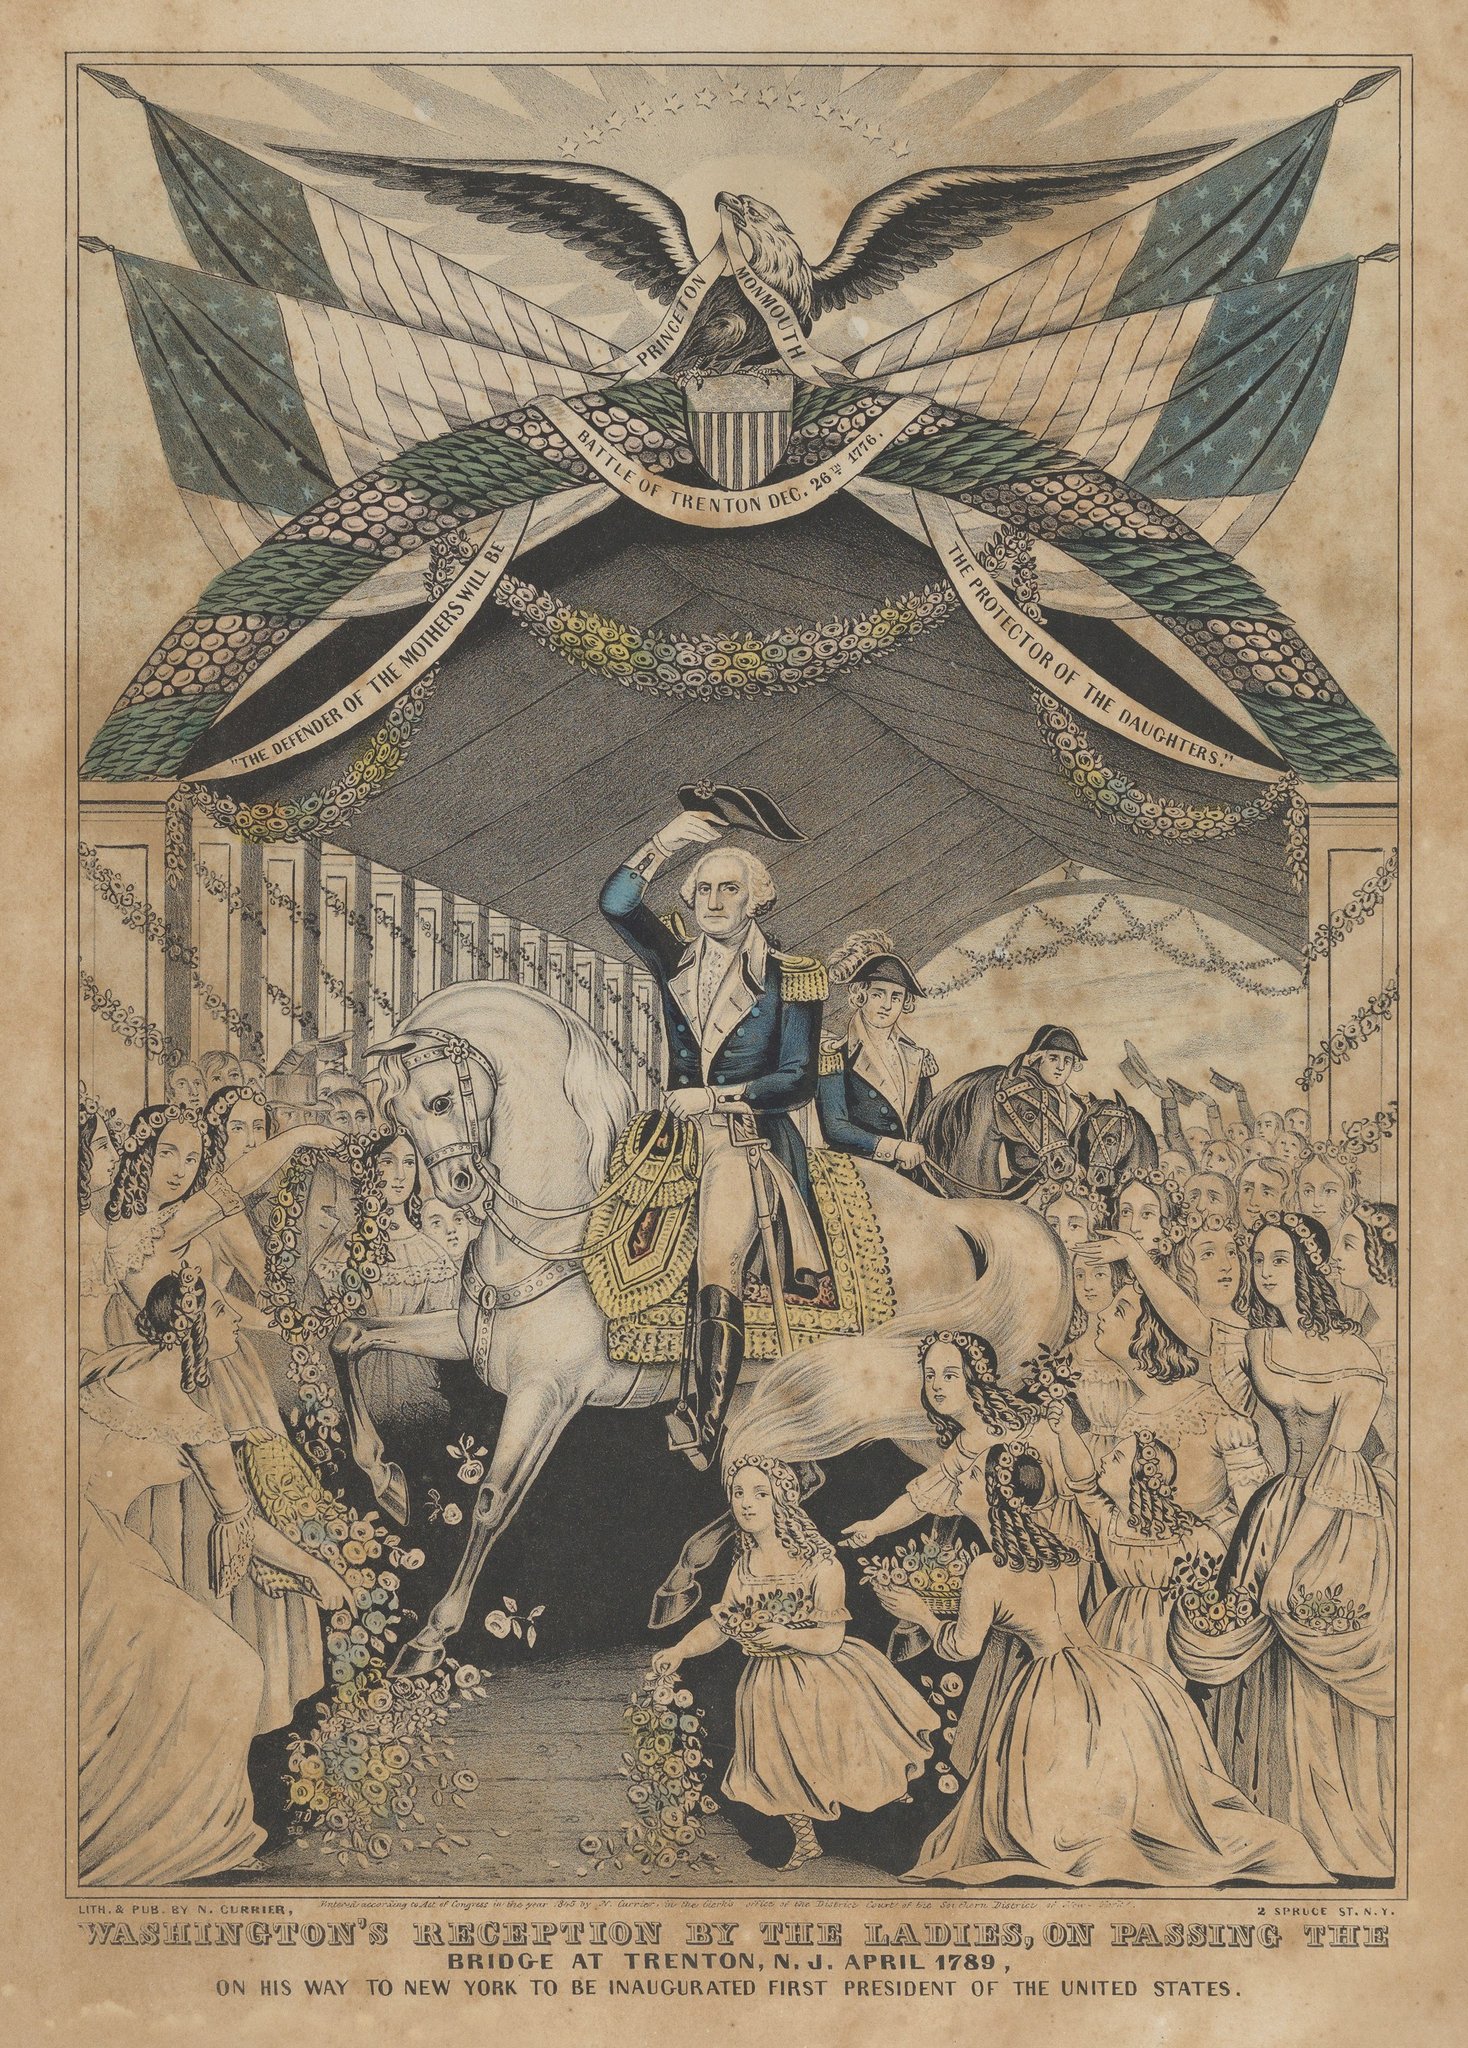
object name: print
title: Washington's Reception by the Ladies on Passing the Bridge at Trenton, N.J., April 1789, on His Way to be Inaugurated First President of the United States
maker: nathaniel currier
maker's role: publisher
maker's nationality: american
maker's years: 1813-1888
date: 1845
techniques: hand coloring, lithograph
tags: george washington,women,horses,coat of arms